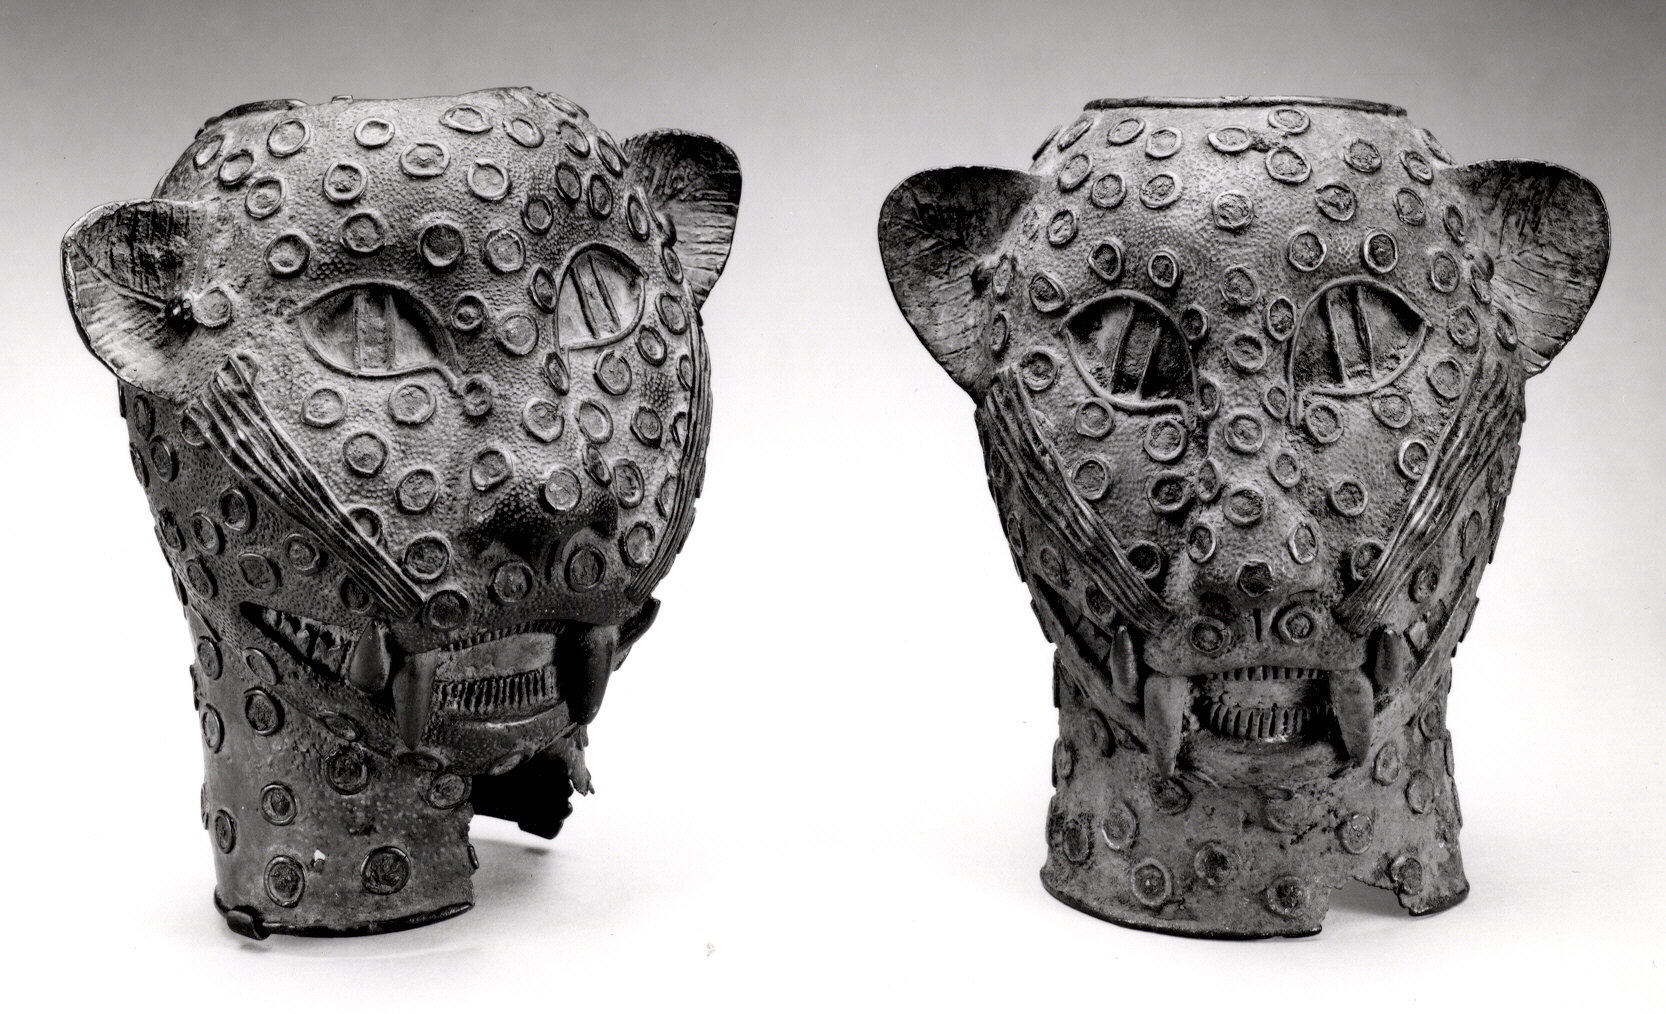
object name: head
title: Figure: Leopard Head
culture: edo period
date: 1701-1900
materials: brass, iron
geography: nigeria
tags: leopards